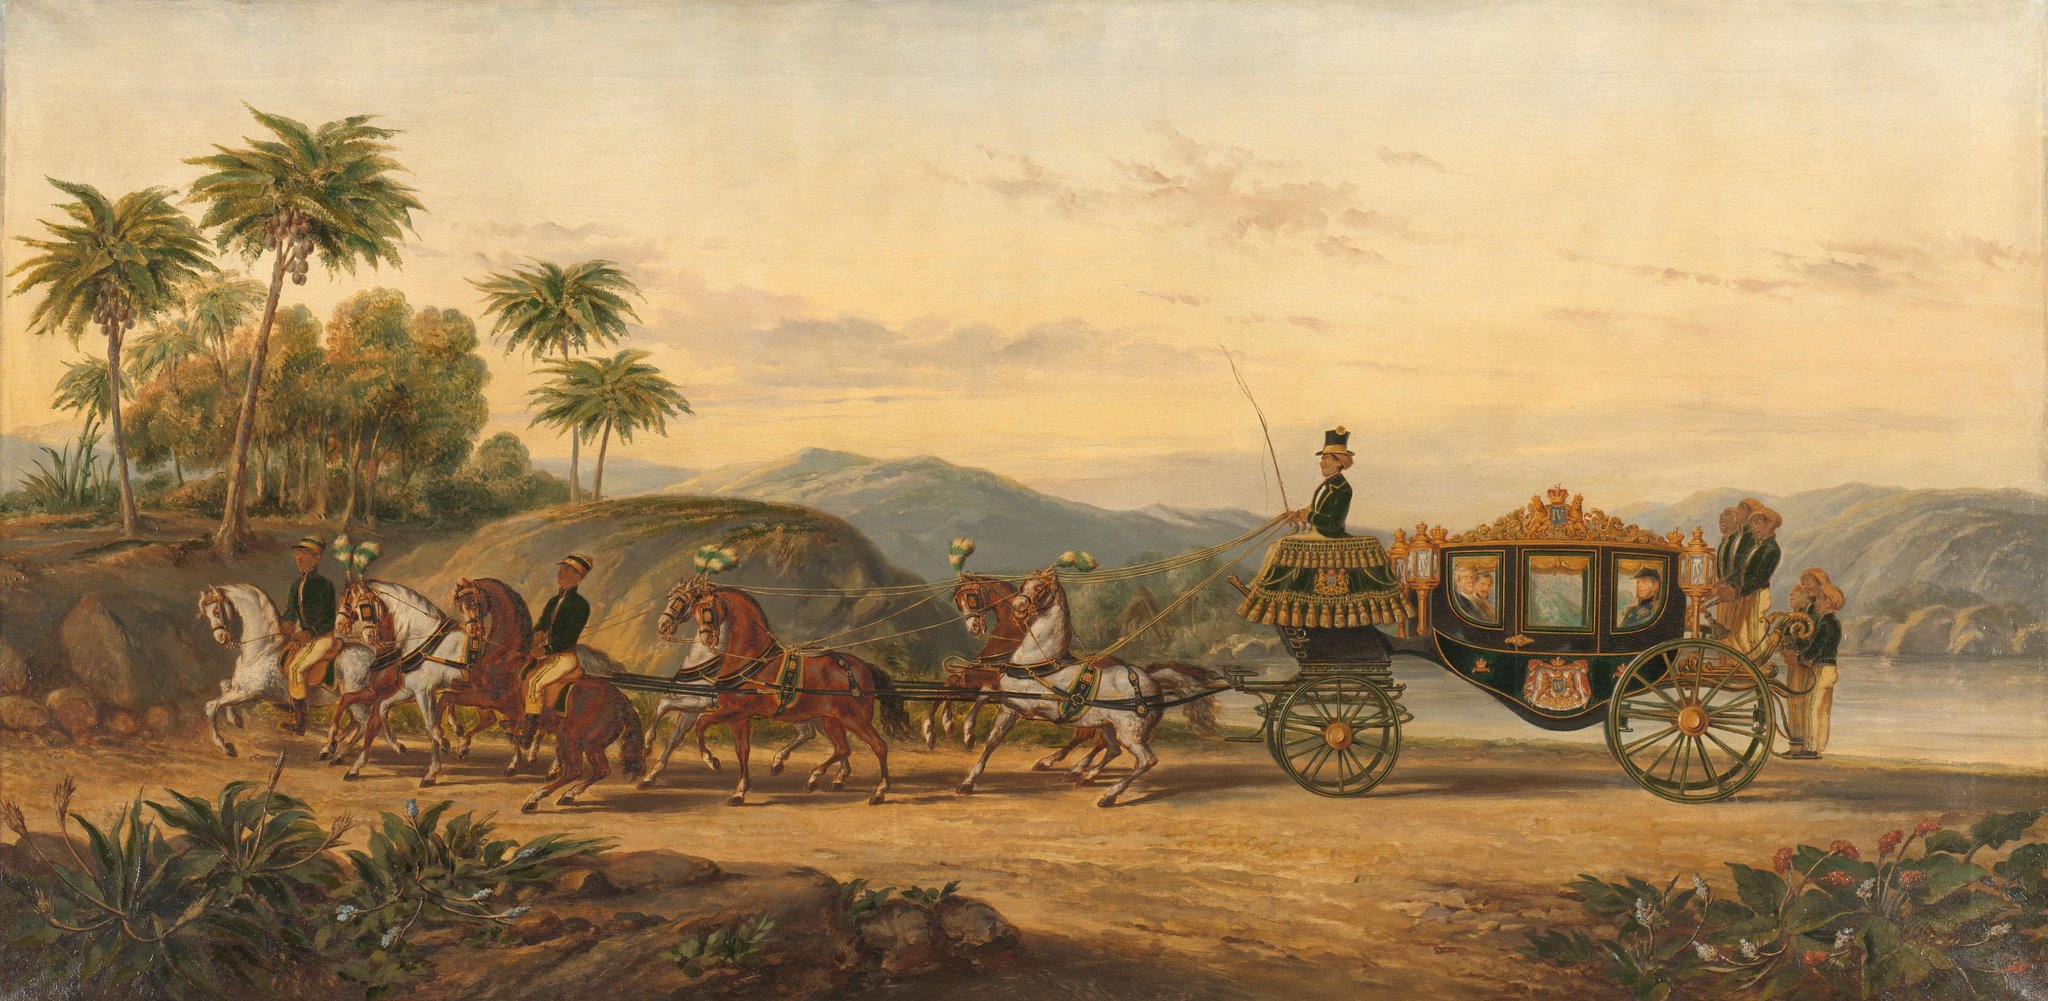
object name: painting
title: The Coach of Mangkoe Nagoro IV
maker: pieter alardus haaxman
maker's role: draughtsman, print maker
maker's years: 1814-1887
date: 1870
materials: canvas, oil, paint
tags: landscapes in tropical and sub-tropical regions, trees: palm-tree, four-wheeled vehicle drawn by more than three animals, the hague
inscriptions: op schilderij IV (6x), etiket achter op spieraam: logo van" British Leyland Motors" en tekst: Inv.nr.: LF 02 190, Lokatie: 20.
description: Haaxman made this painting as a kind of advertisement for The Hague firm of carriage makers Hermans en Co. The coach depicted was ordered by the Javanese sultan Mangkoe Nagoro IV. The Roman numeral IV, a reference to the Javanese ruler, can be seen in the Dutch coat of arms on the door of the carriage. Around 1900, the authority of the local rulers was sometimes closely intertwined with that of the colonial regime.